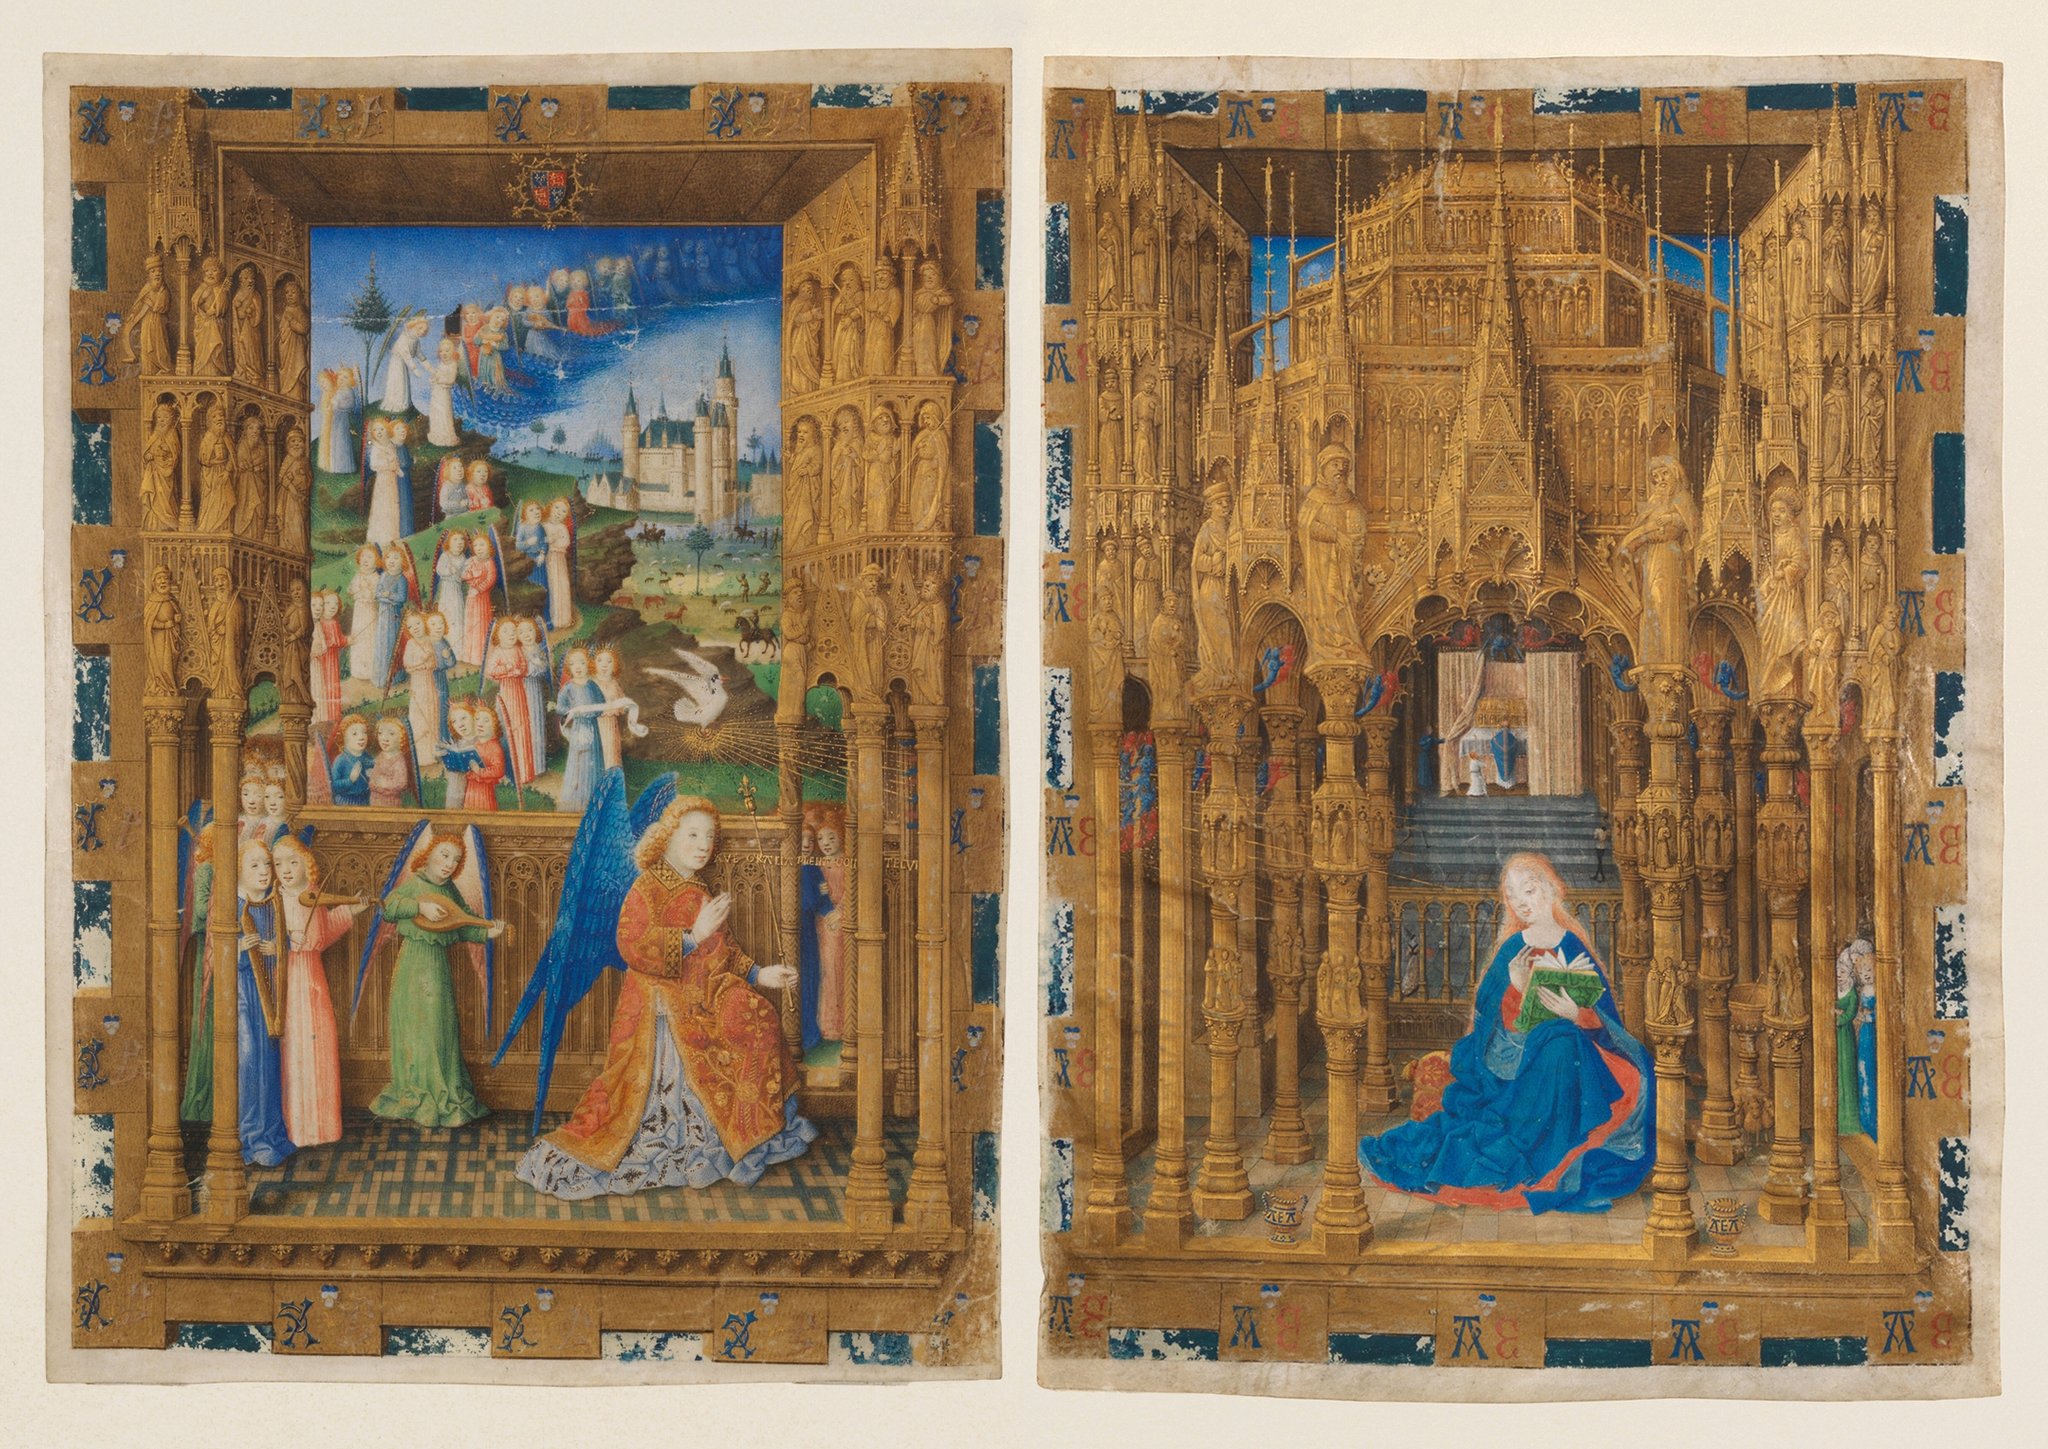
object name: book of hour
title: The Annunciation from the Hours of Charles of France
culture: french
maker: master of charles of france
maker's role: artist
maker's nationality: french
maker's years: 1425-1550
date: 1465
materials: gold, ink, parchment, paint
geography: france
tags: interiors,angels,virgin mary,annunciation